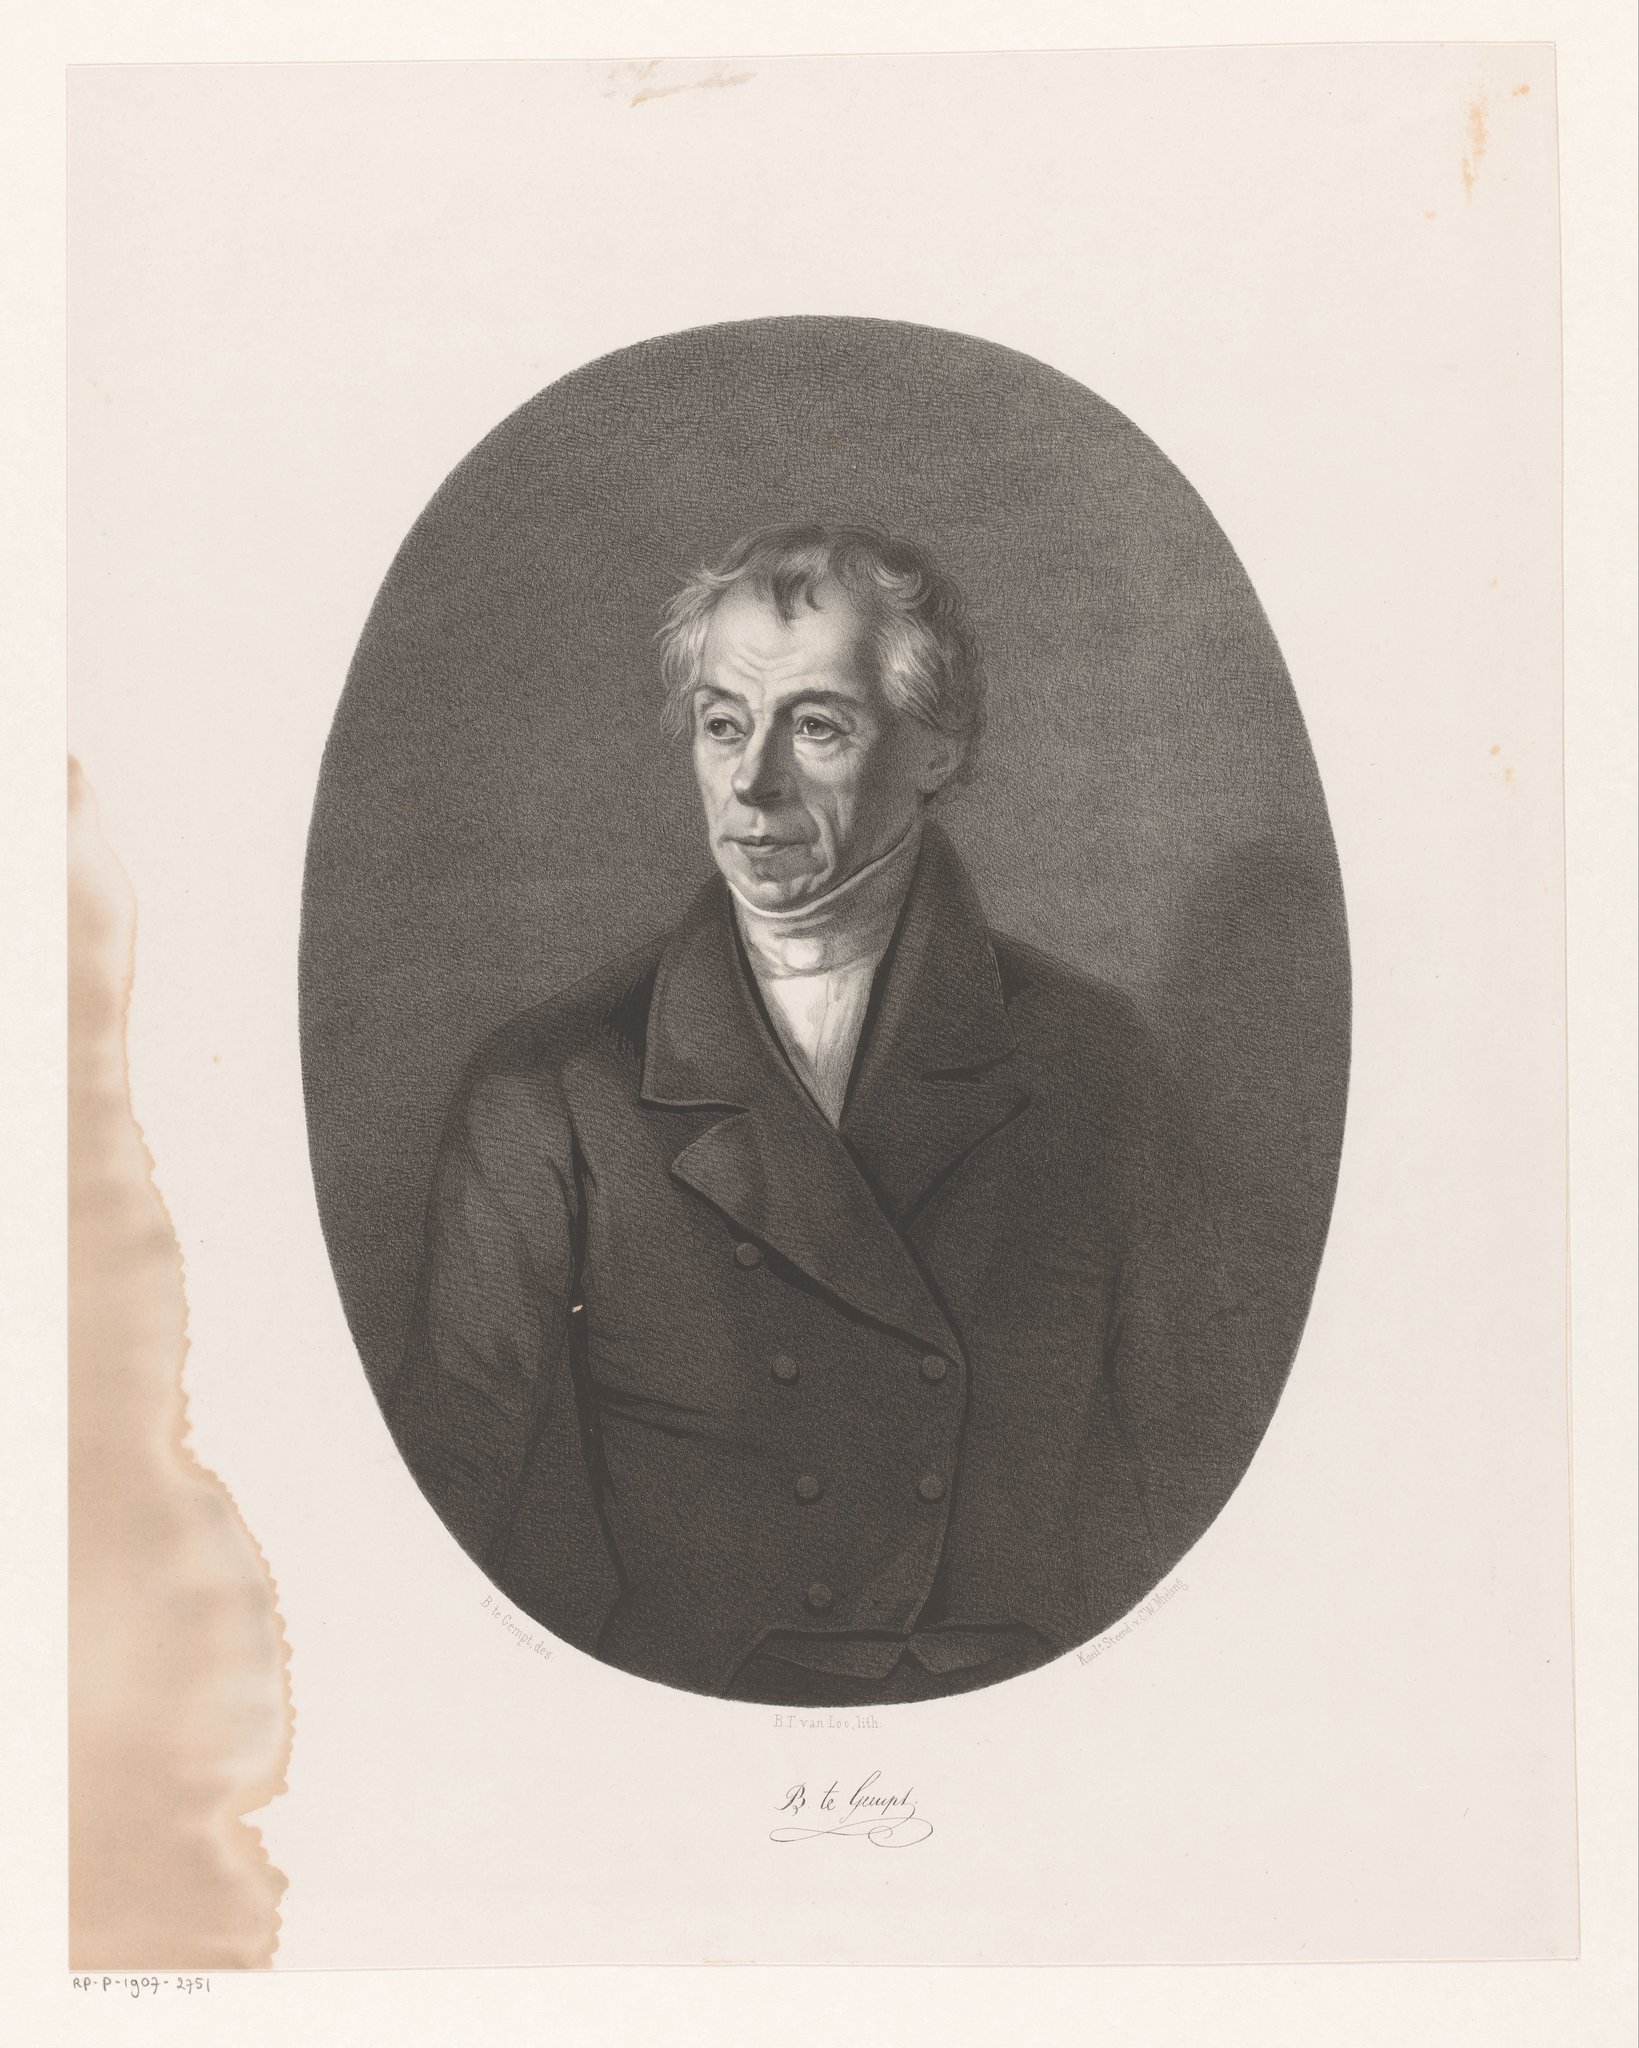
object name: print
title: Portret van Bernhardt te Gempt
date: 1836-1892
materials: paper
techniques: lithograph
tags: historical persons (+ (full) bust portrait)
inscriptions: collector's mark: Lugt 2228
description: Onder het portret de signatuur van de geportretteerde.